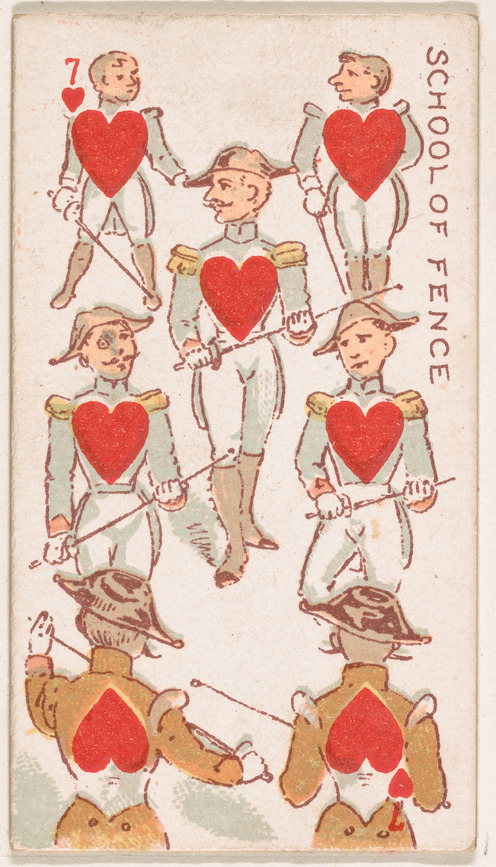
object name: print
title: Seven of Hearts, School of Fence, from Harlequin Cards, 2nd Series (N220) issued by Kinney Bros.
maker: kinney brothers tobacco company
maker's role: publisher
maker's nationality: american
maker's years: 1869-2011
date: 1889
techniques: color lithograph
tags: playing cards